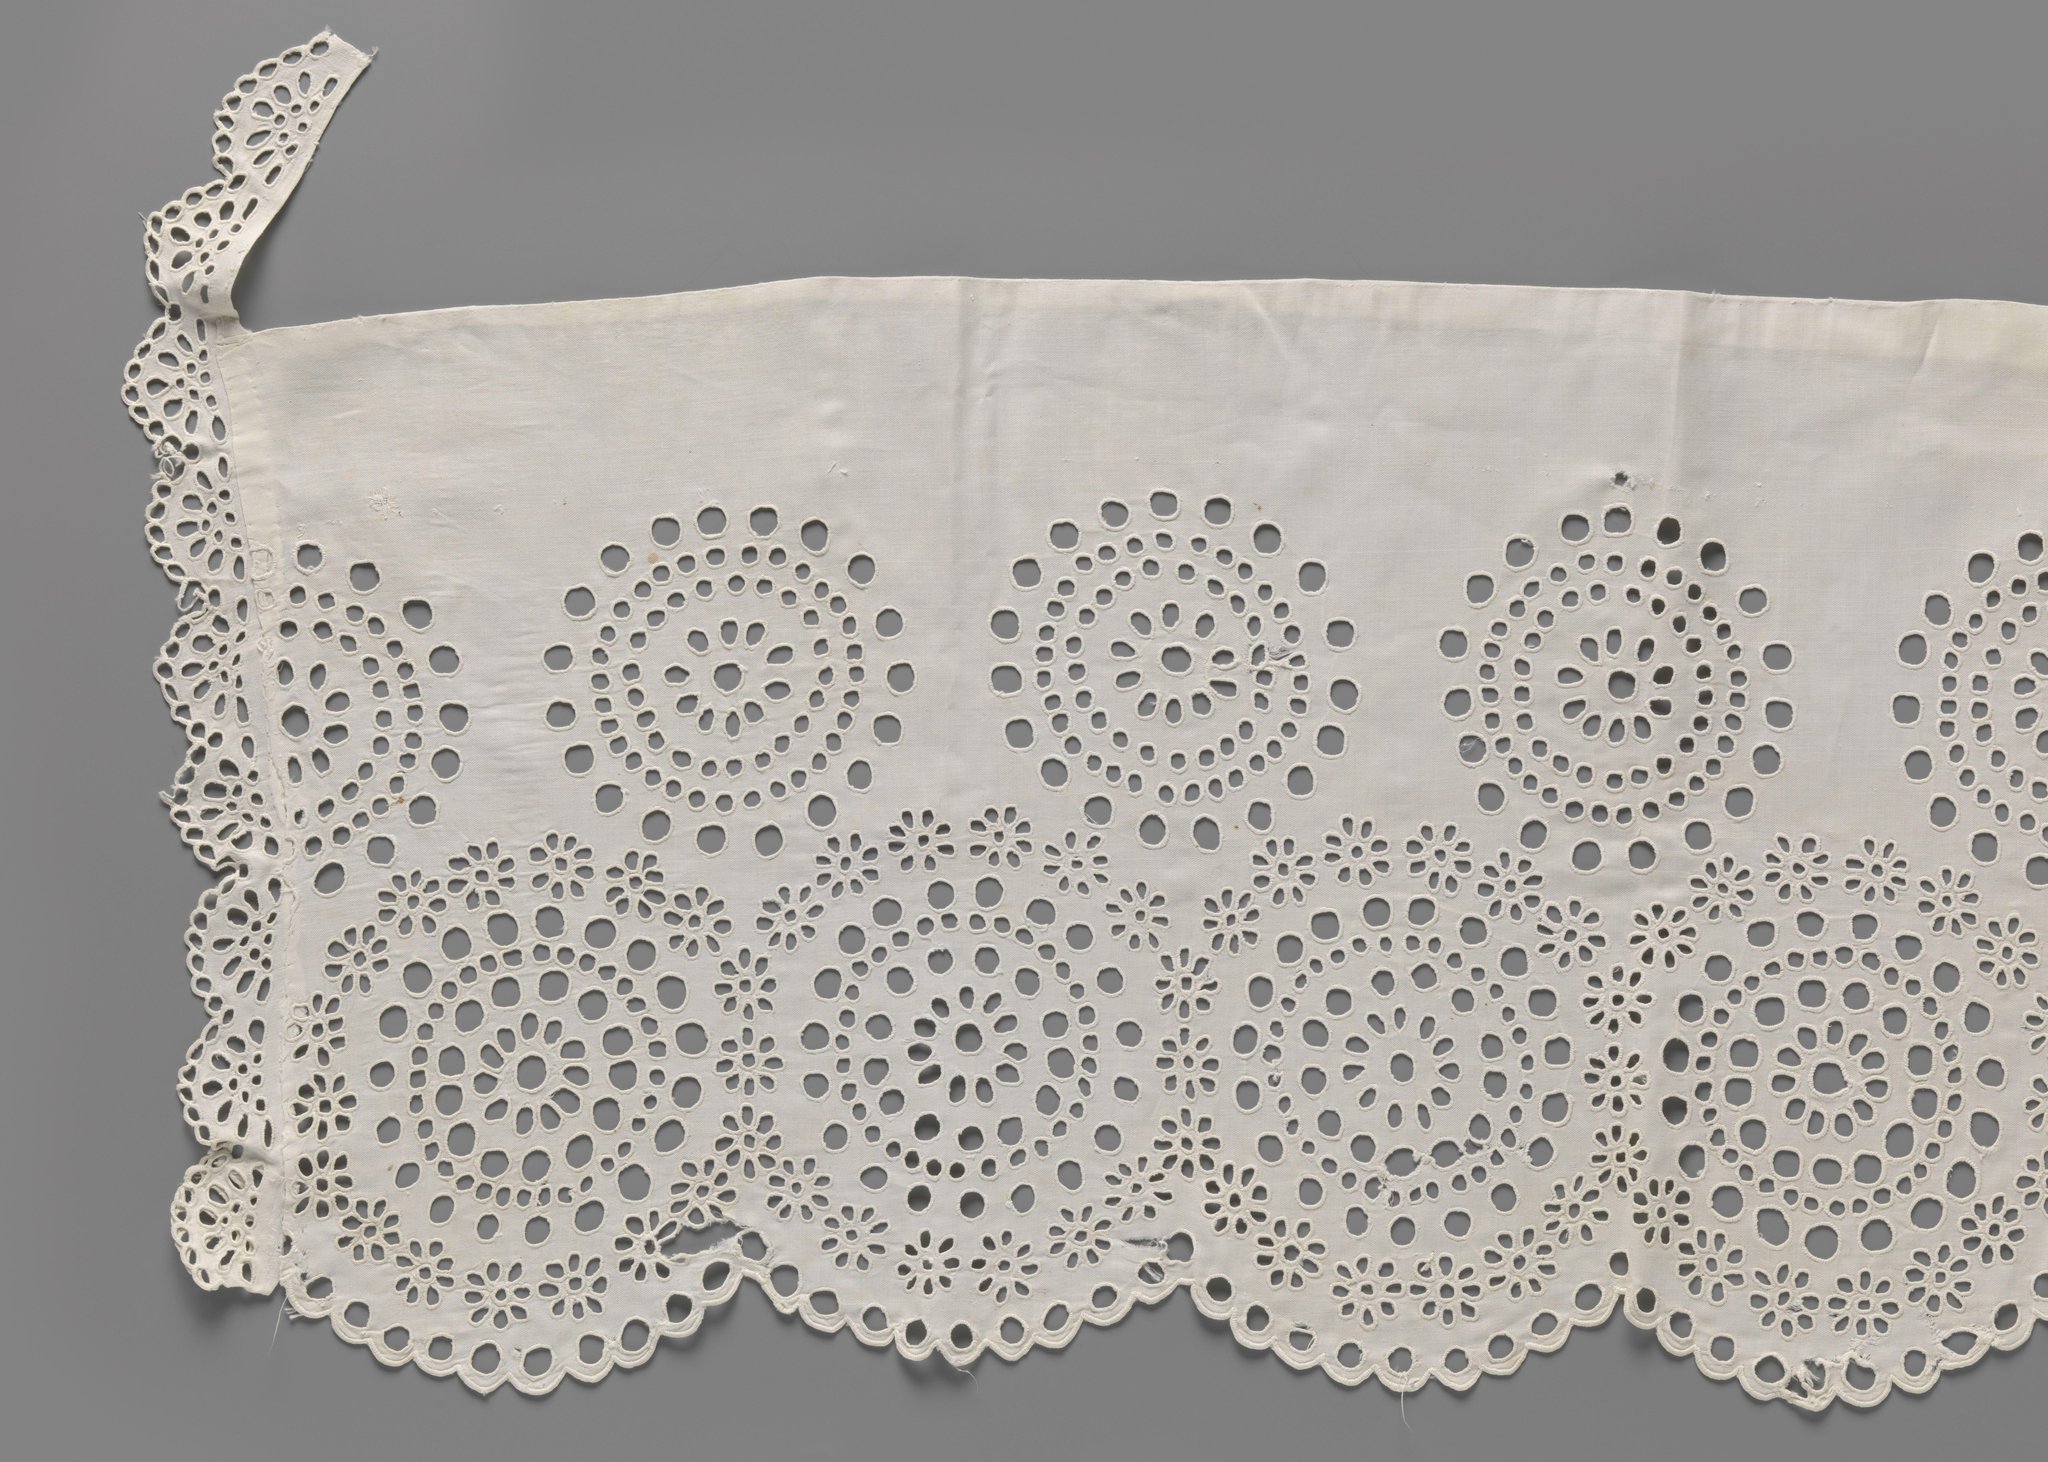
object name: strip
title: Strook katoen met kantborduurwerk met opengewerkte concentrische cirkels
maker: c.i. bosch reitz-teding van berkhout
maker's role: kantwerkster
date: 1860-1880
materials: cotton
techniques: weave, embroidery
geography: amsterdam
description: Strook naturelkleurig katoen met kantborduurwerk: Engels borduurwerk. Schulpenrand met grote schulpen waarboven twee verspringende rijen concentrische cirkels, opgebouwd uit drie steeds groter wordende cirkels en in het midden een margriet. De onderste rij heeft bovendien aan de buitenkant nog een extra cirkel die bestaat uit kleine margrietjes. De andere cirkels zijn opgebouwd uit opengewerkte kleine en grotere cirkeltjes. Langs de schulpenrand loopt een doorgaande lijst van opengewerkte cirkeltjes. Langs één van de korte zijden is een schulpenstrook genaaid met kleinere schulpen.